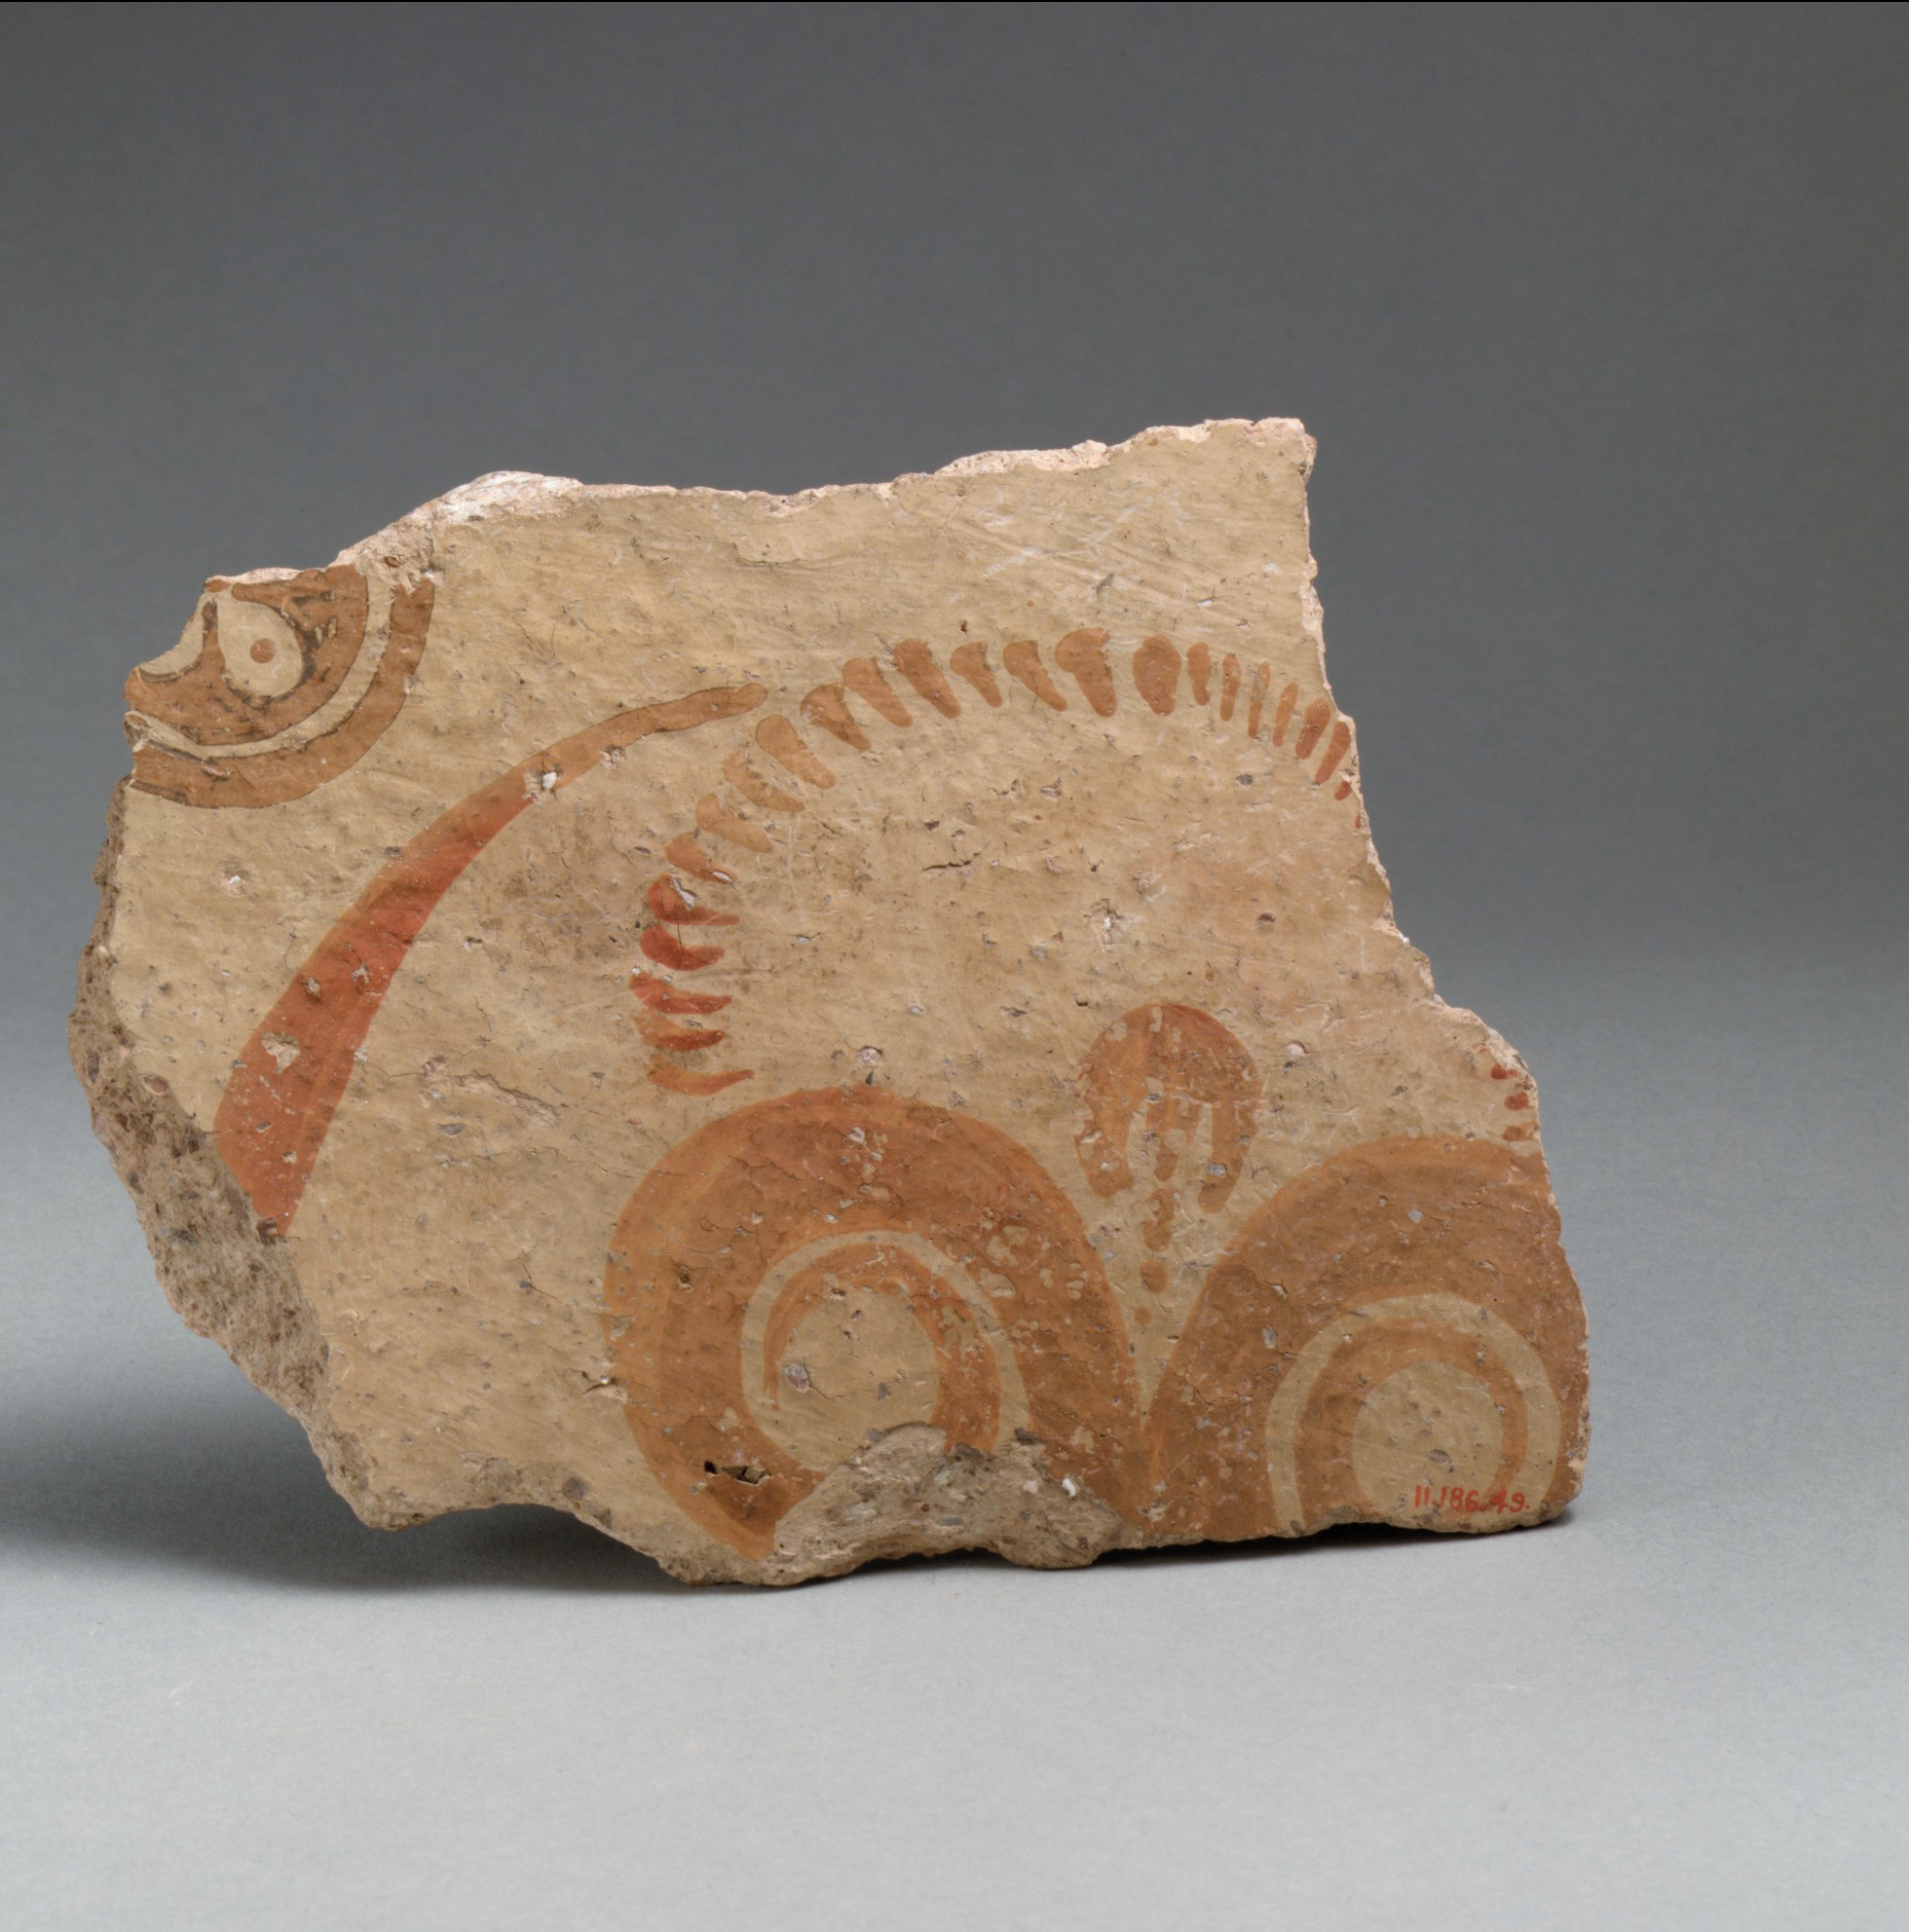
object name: vase fragment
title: Terracotta vessel fragment with conventionalized lily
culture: minoan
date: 1450-1400 BCE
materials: terracotta